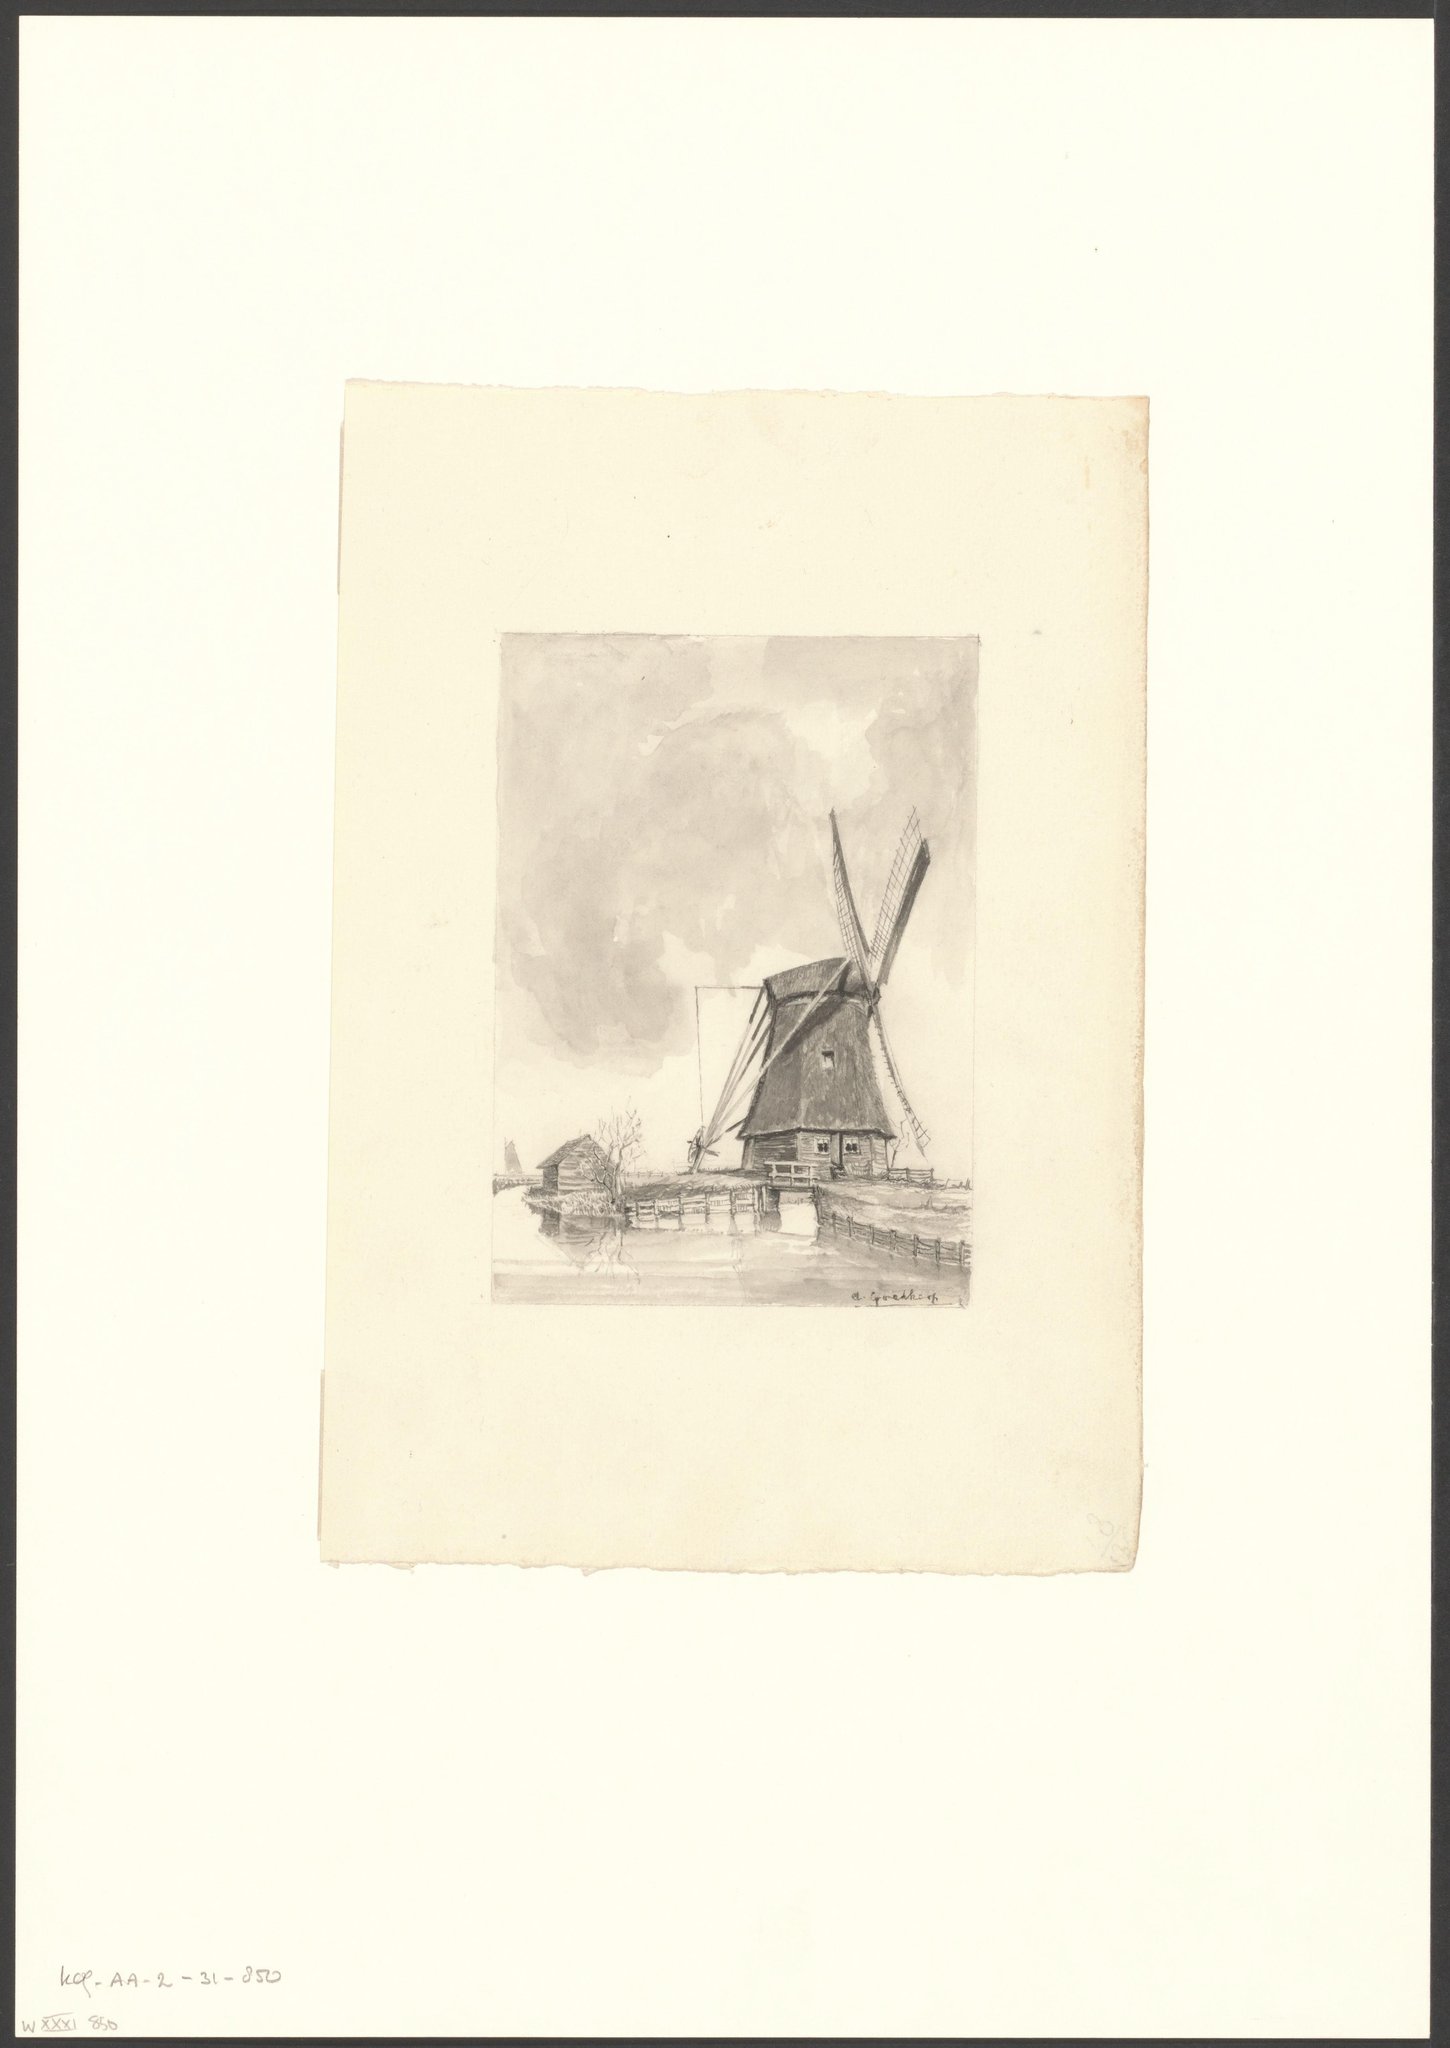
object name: drawing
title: Gezicht op de Koenenmolen aan de Nieuwe Meer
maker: goedkoop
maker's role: draughtsman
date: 1850-1919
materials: ink, paper, pencil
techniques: brush, pen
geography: amsterdam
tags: city-view in general; 'veduta', lake, windmill in landscape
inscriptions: signature: ‘a. Goedkoop’, inscription: ‘Koene Molen’, collector's mark: Lugt 800a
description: Tekening binnen de Atlas Van Eck ingedeeld op wijknummer 31.